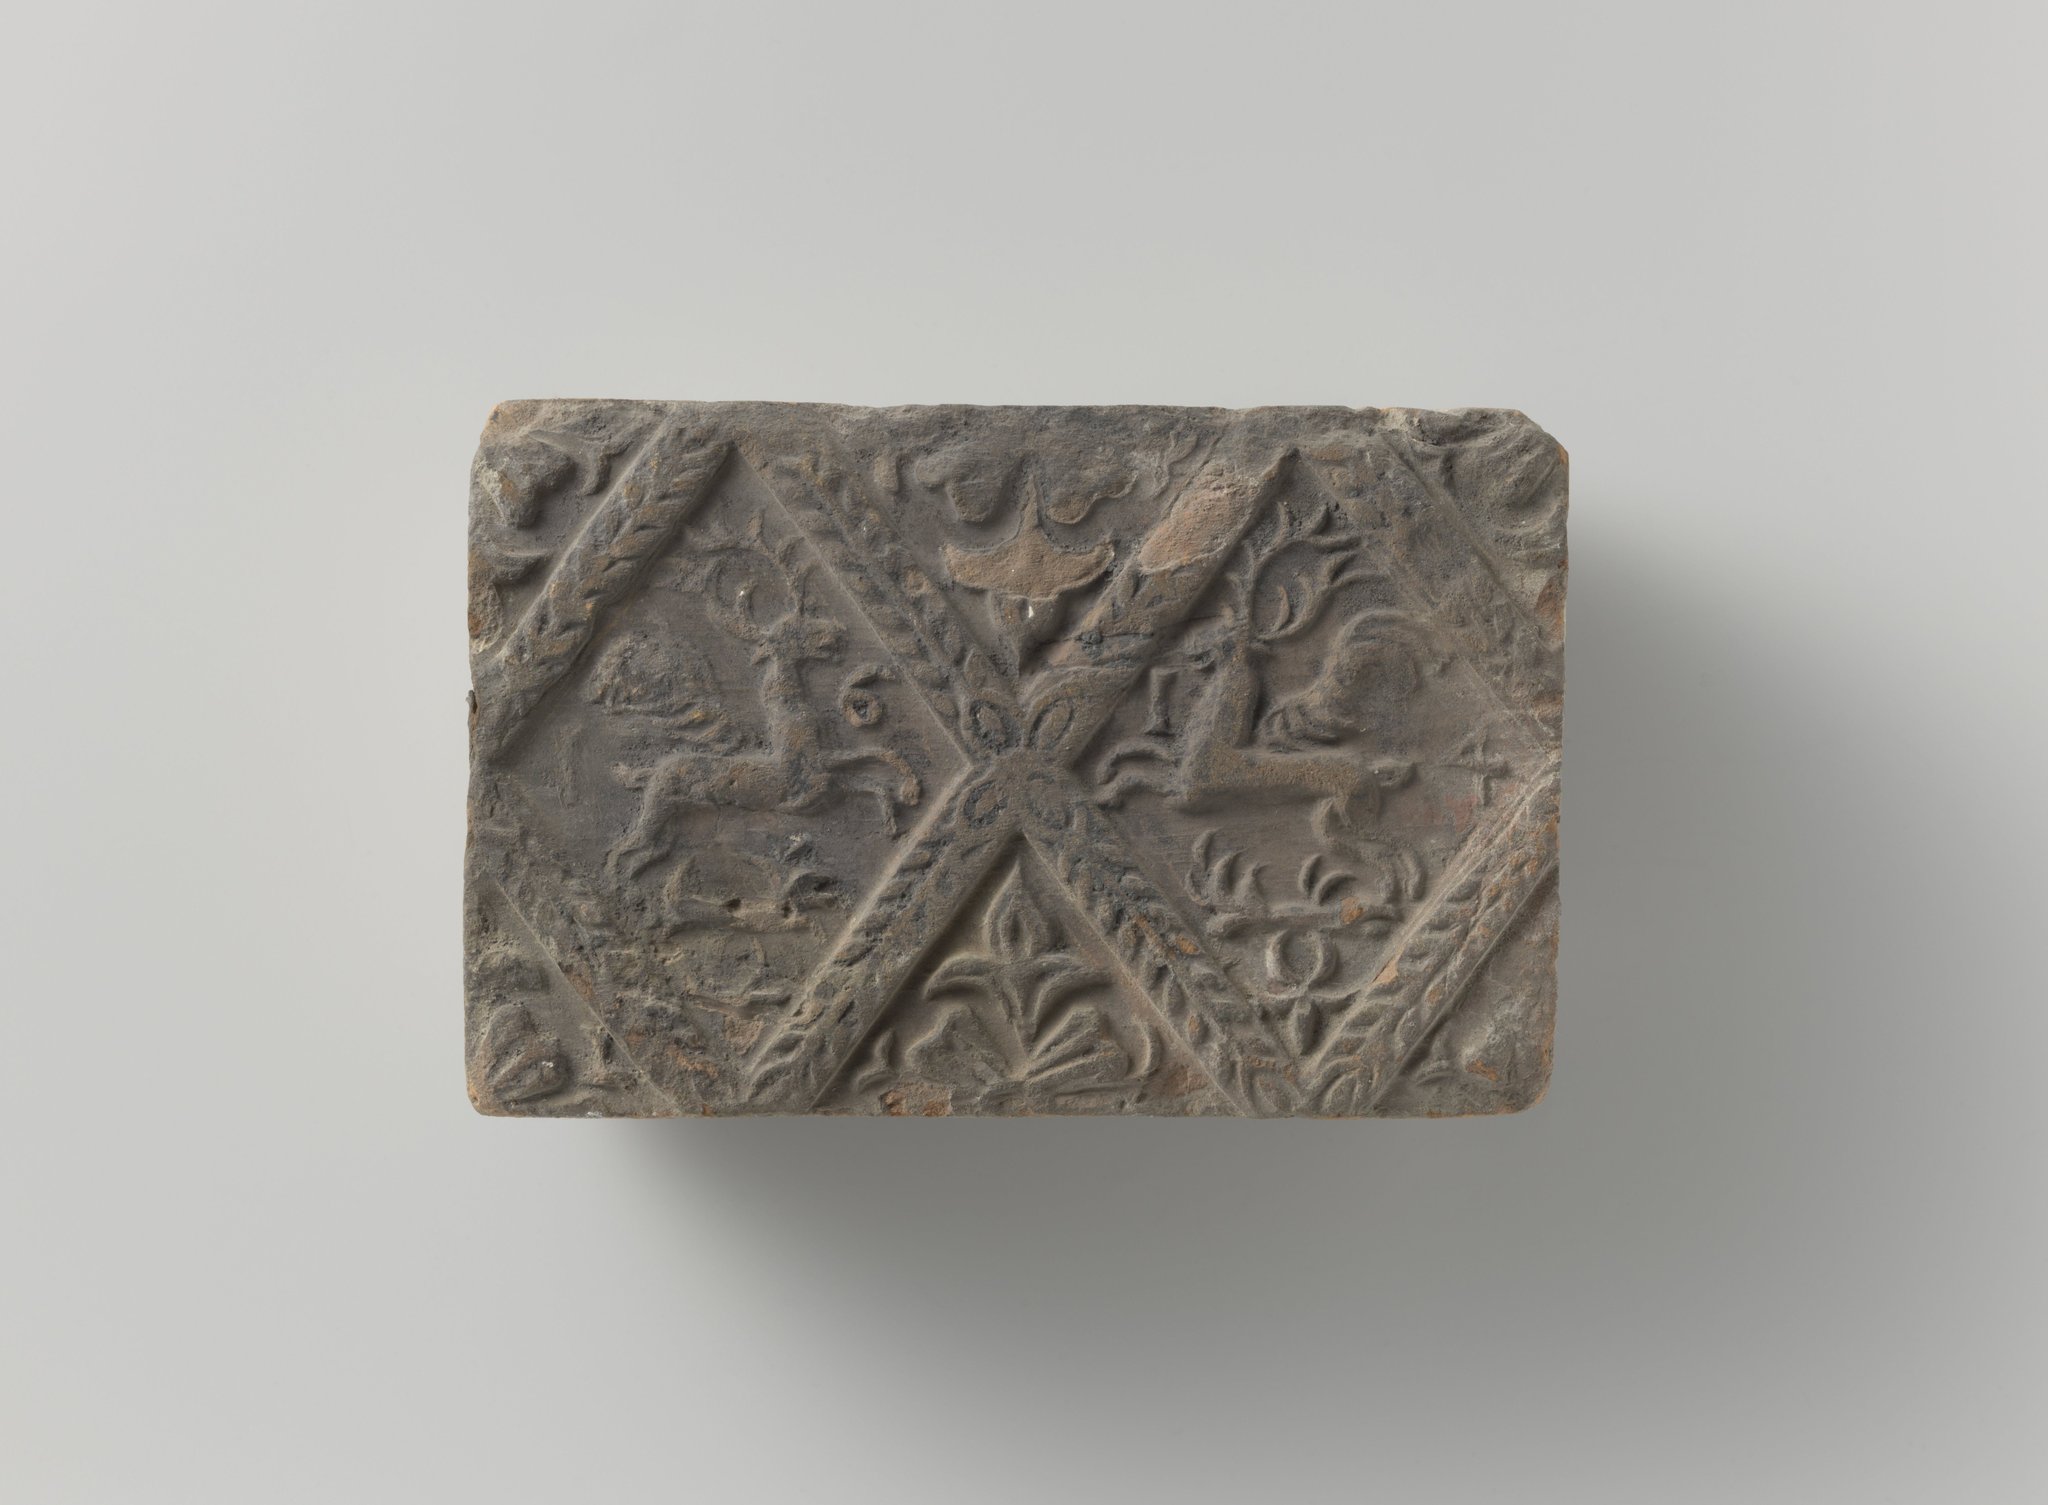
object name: hearthstone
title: Haardsteen met gevleugelde en naar elkaar toe rennende herten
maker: Anonymous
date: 1614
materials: earthenware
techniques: firing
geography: southern netherlands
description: Haardsteen met gevleugelde en naar elkaar toe rennende herten. Door ruiten gedeeld, in twee waarvan het jaartal 1614. In de gedeelten van de verdere ruiten een lelie (?). Gebakken. Zeer geschonden.